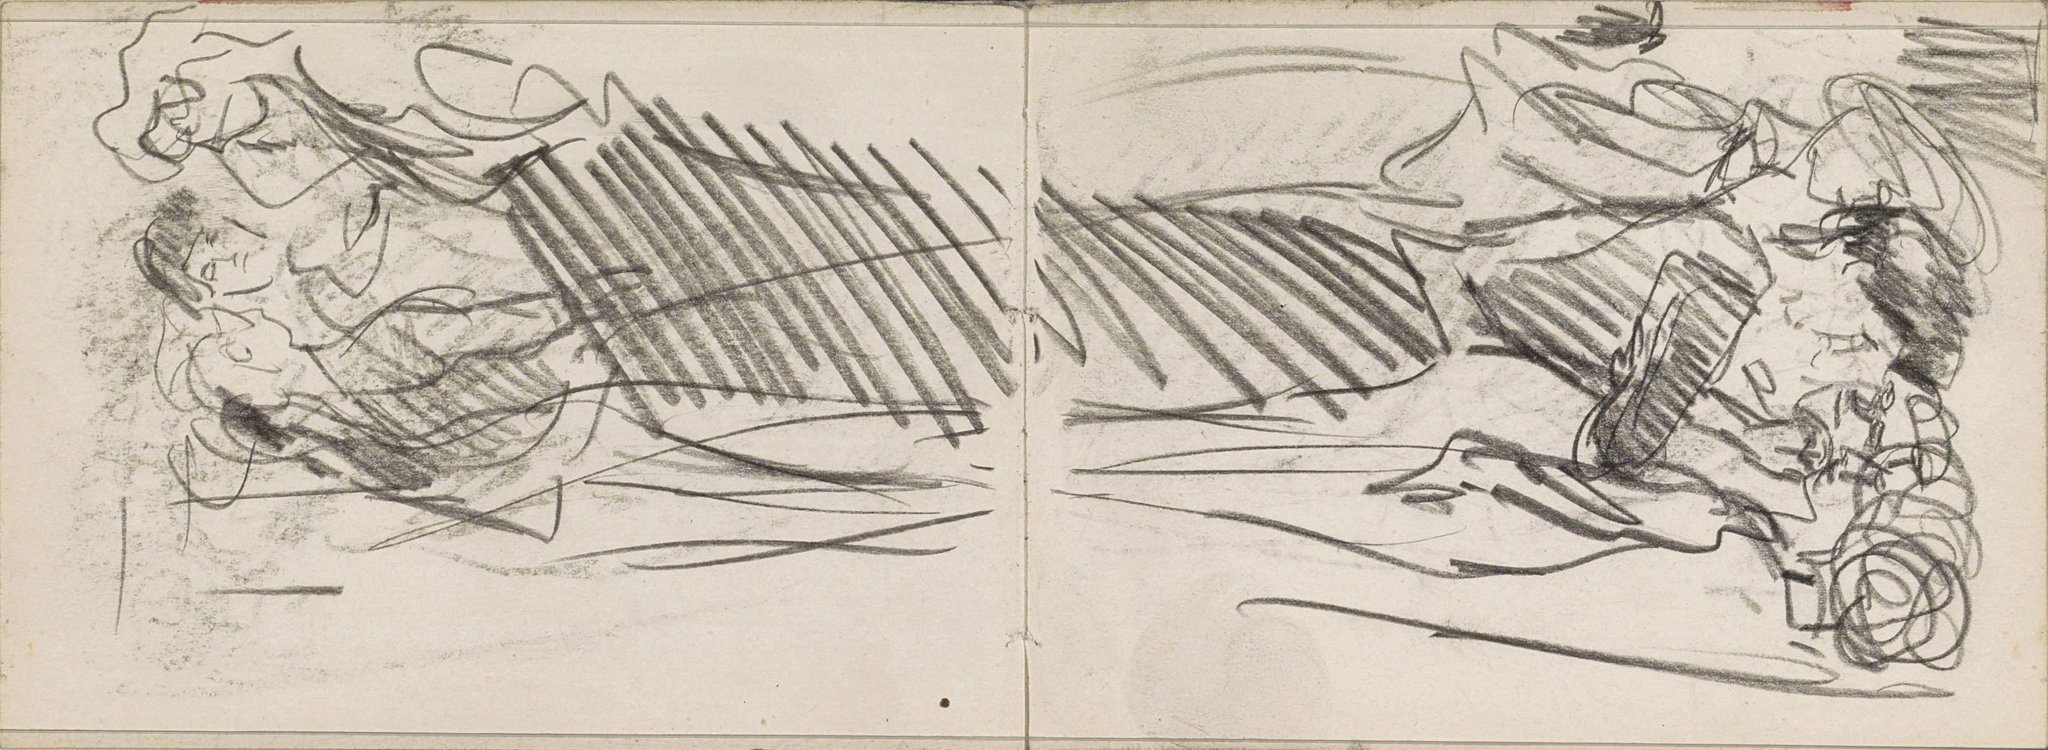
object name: sketchbook leaf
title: Groep staande vrouwen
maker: isaac israels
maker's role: draughtsman, painter, print maker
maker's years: 1865-1934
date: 1875-1934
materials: chalk, paper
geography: paris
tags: adult woman (+ standing)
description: Pagina 53 en pagina 54 uit schetsboek XLV met 85 pagina's.